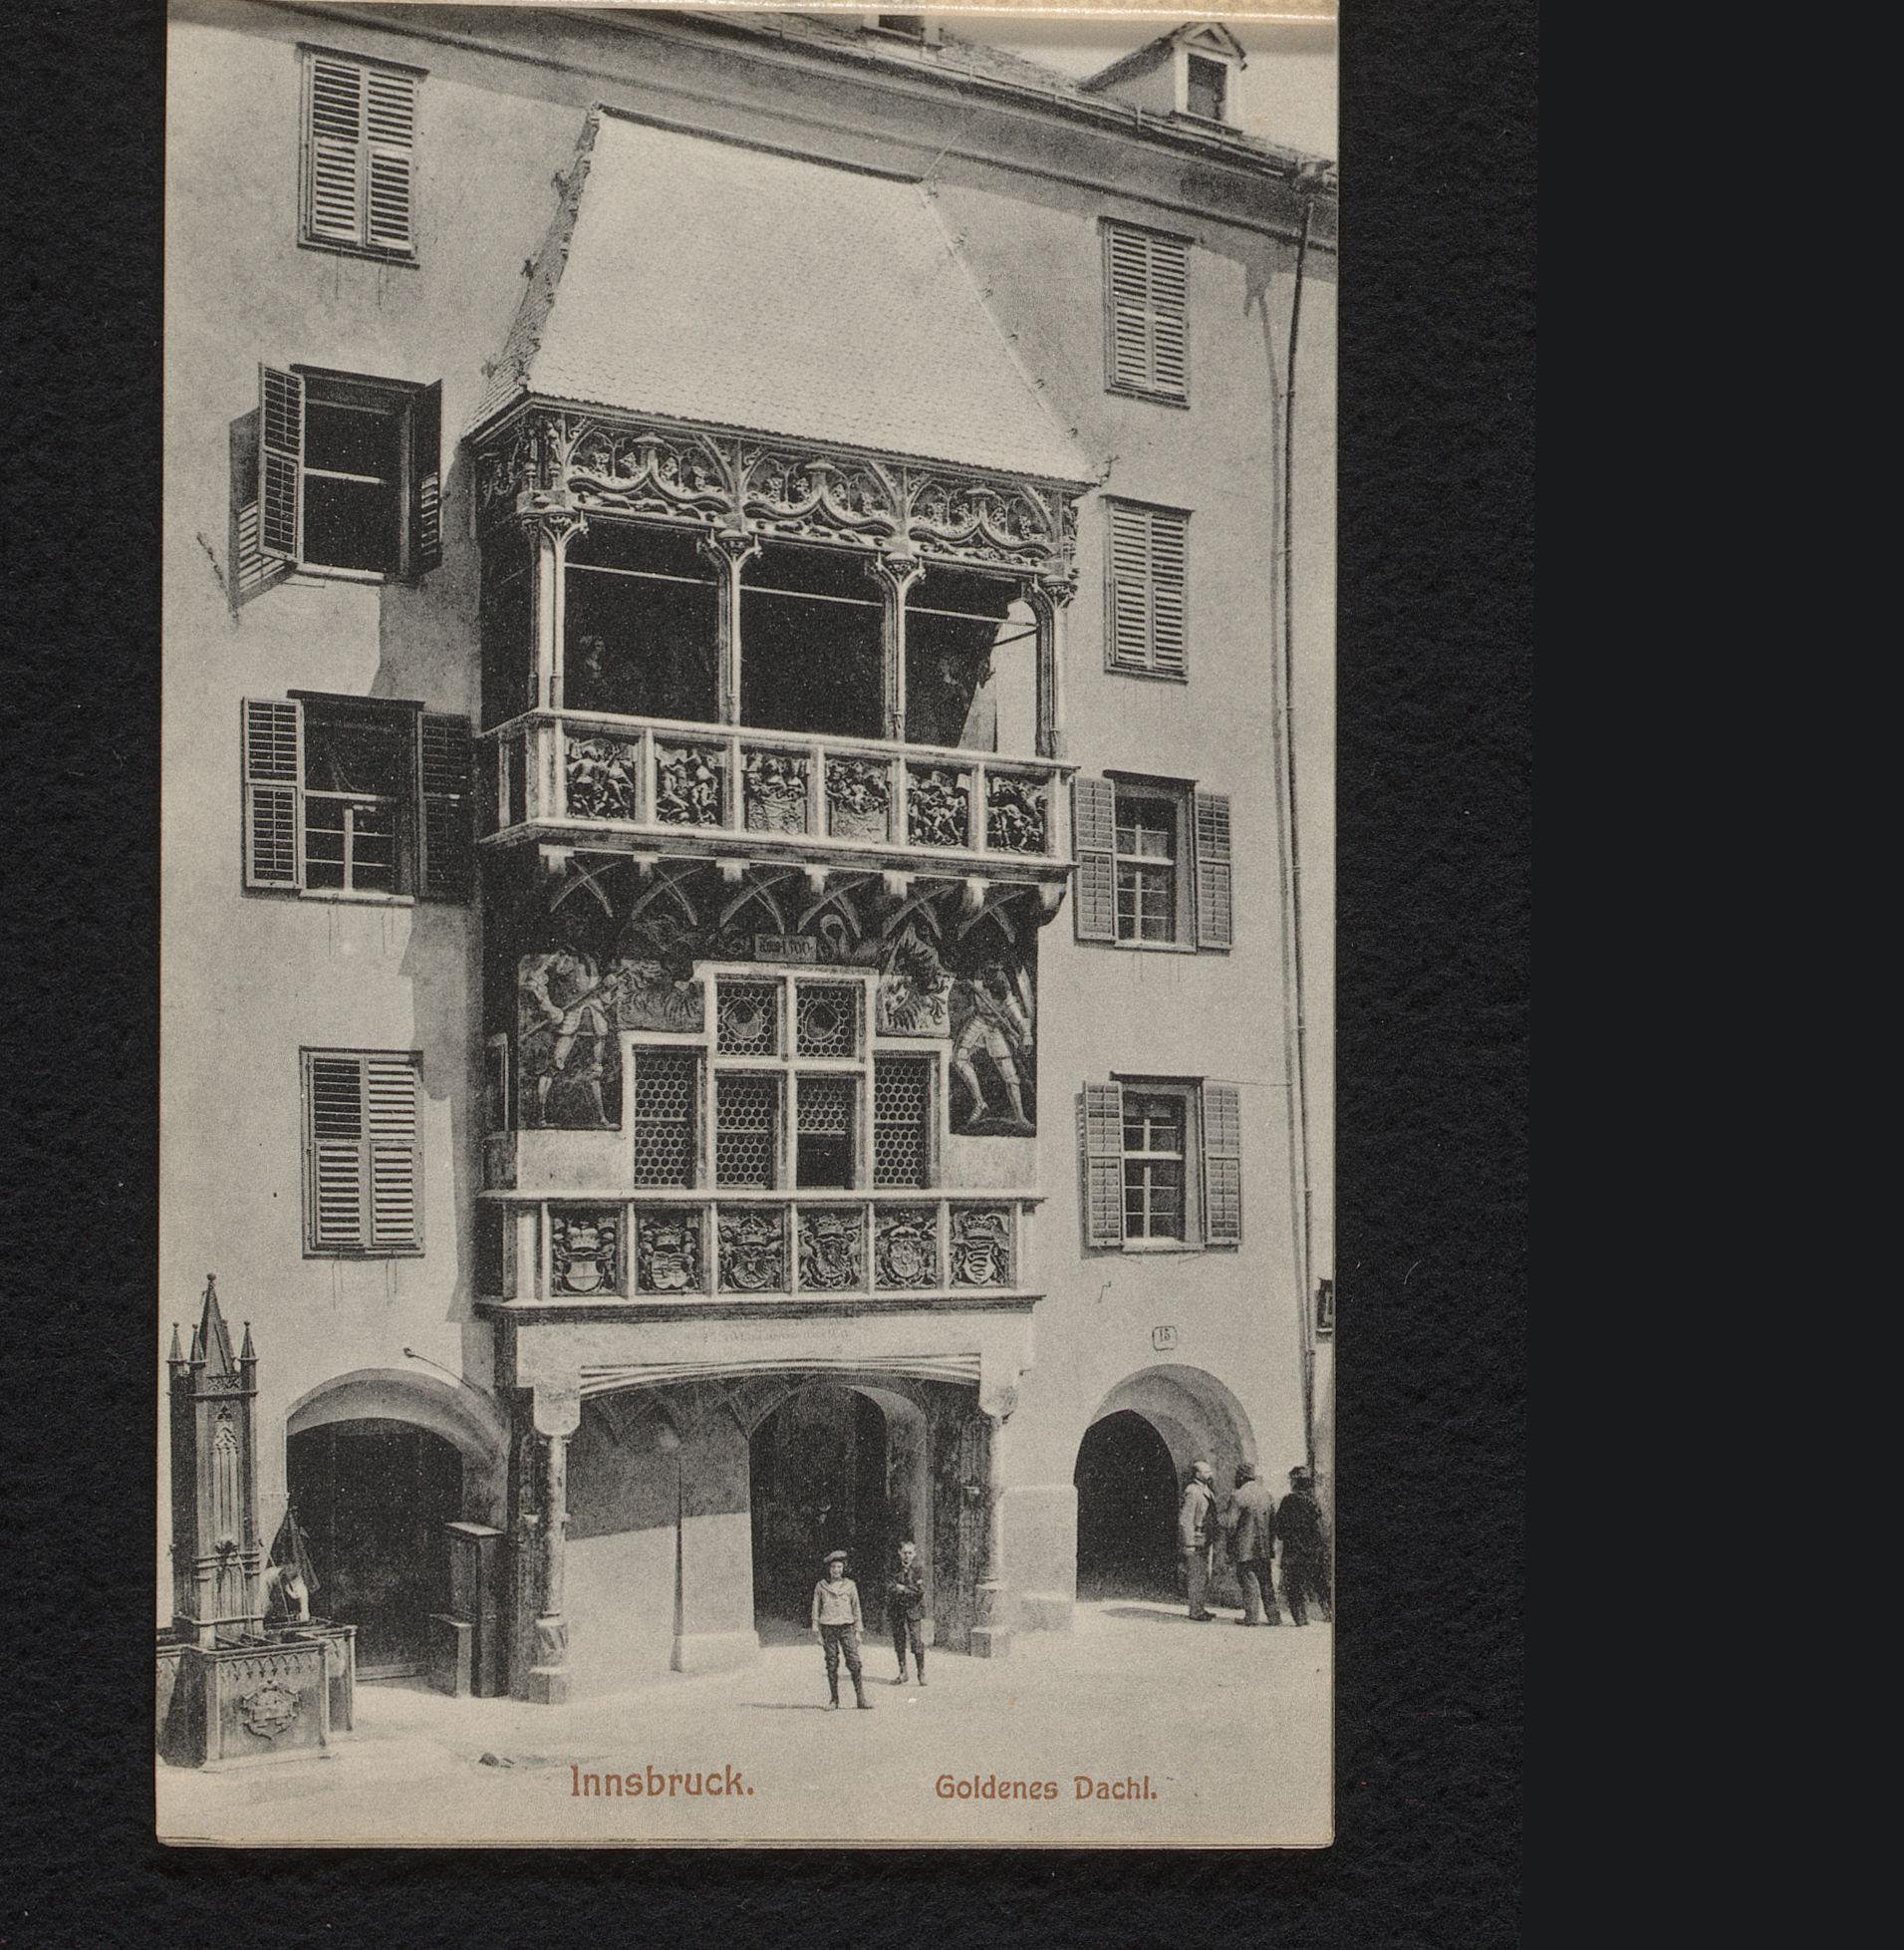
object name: ansichtkaart, prentbriefkaart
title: Innsbruck. Goldenes Dachl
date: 1904-1930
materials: cardboard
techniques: photograph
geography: innsbruck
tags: roof (of house or building), housing